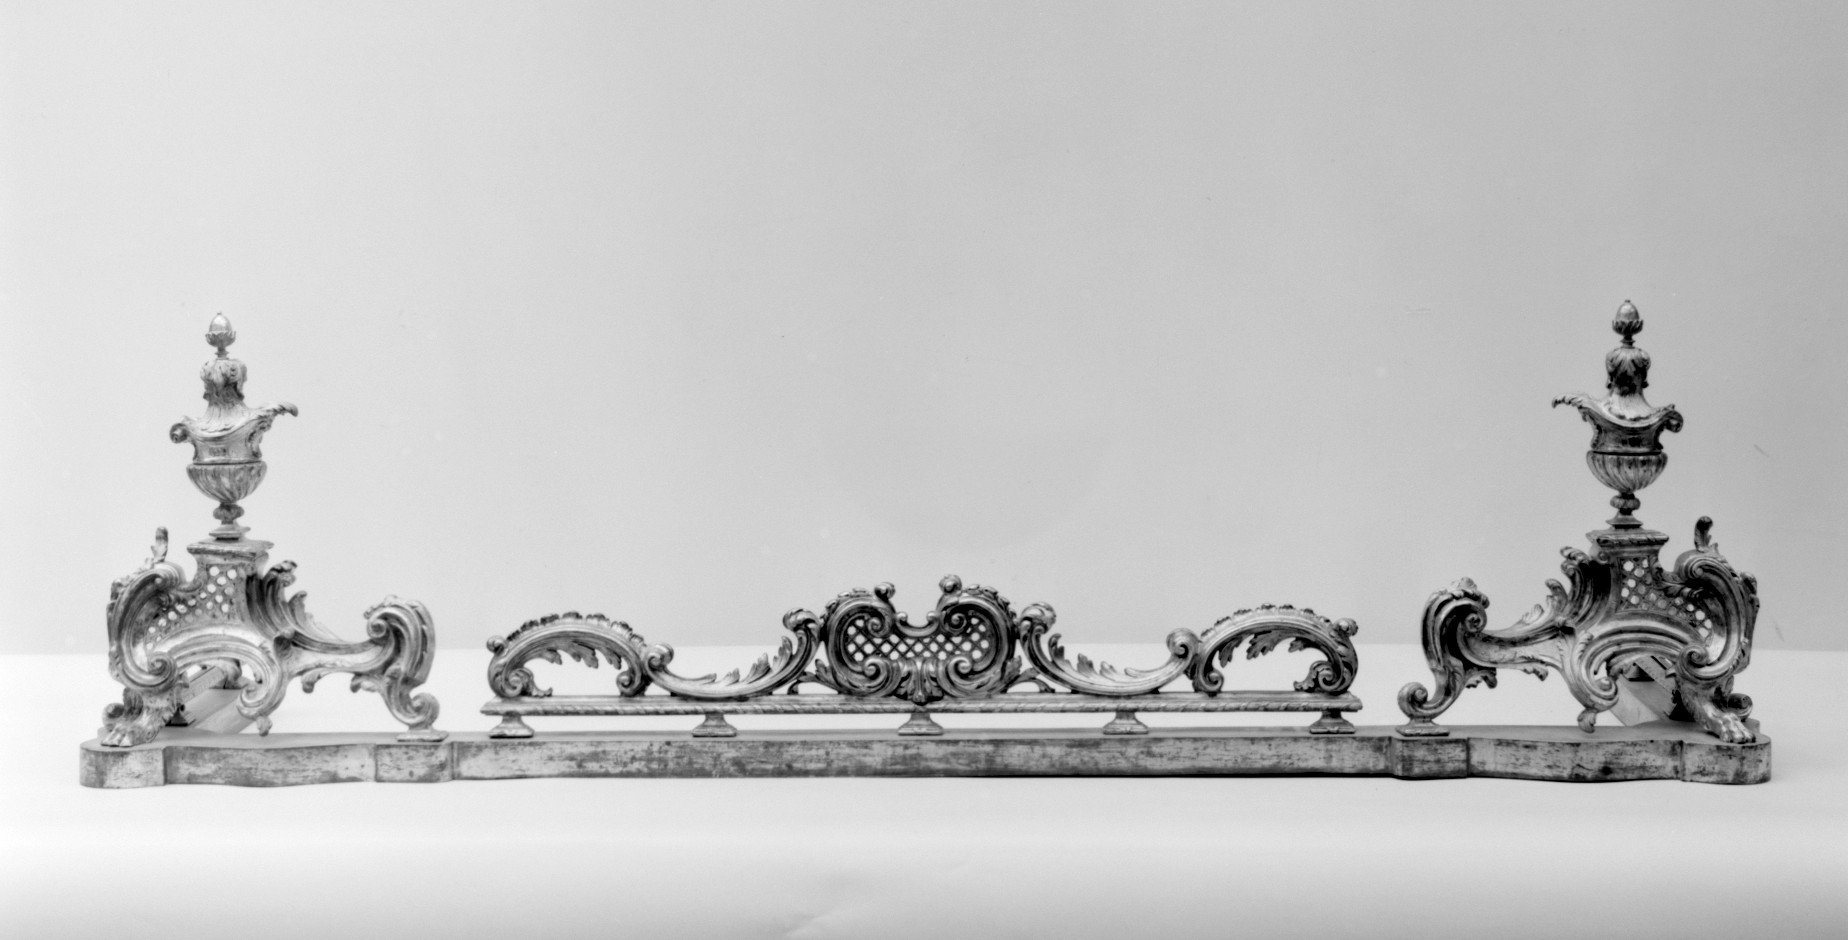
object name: fireplace fender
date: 1734-1766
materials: gilt bronze